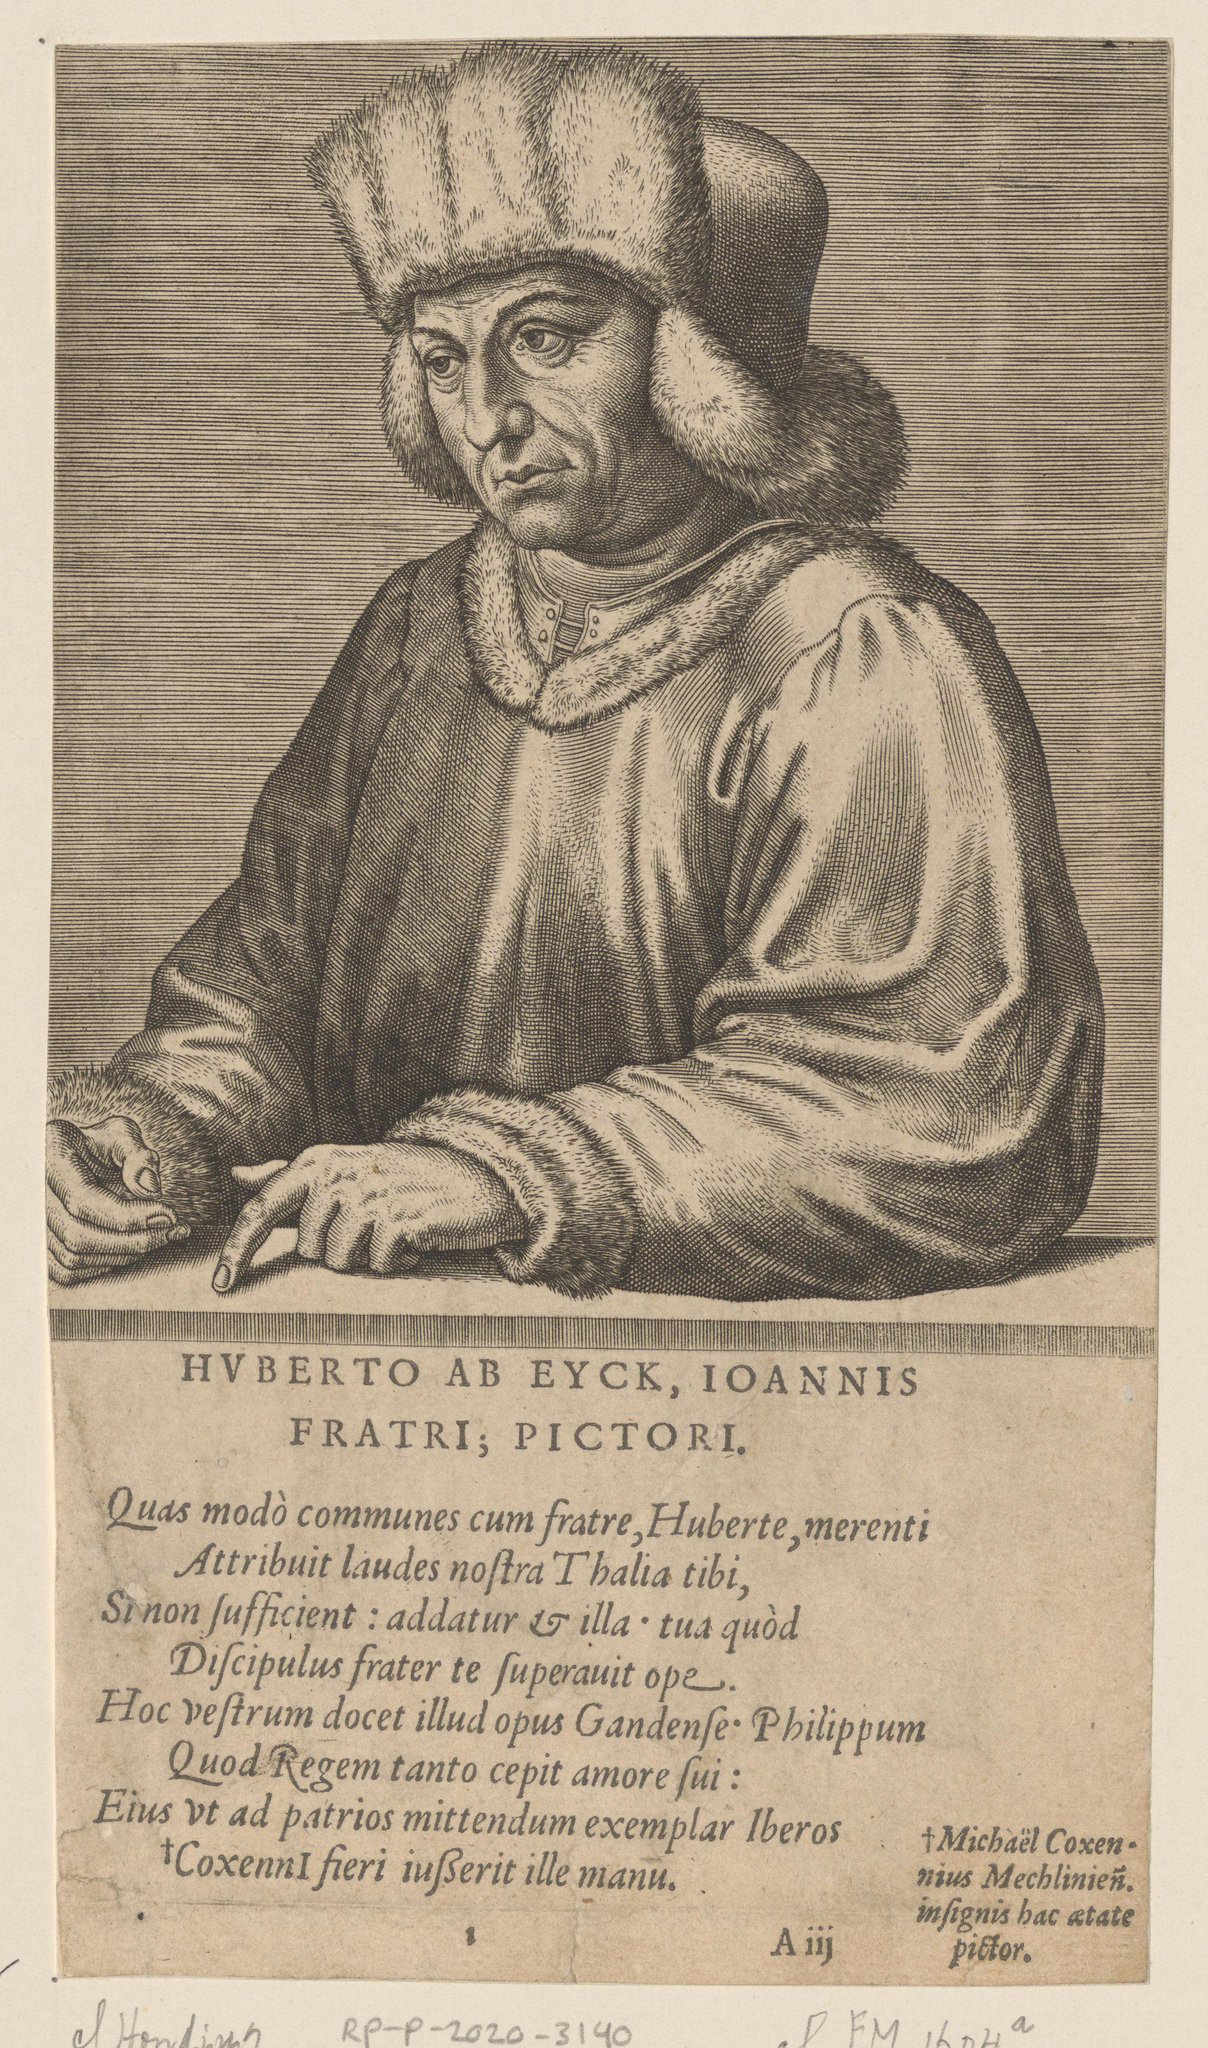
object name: print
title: Portretten van schilders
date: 1572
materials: paper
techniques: engraving, letterpress printing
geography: antwerp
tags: ghent, hubert van eyck, historical persons, portrait, self-portrait of painter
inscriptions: collector's mark: Lugt 2165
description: Met achtregelig lofdicht in het Latijn. Midden onder genummerd: 1 en Aiij.